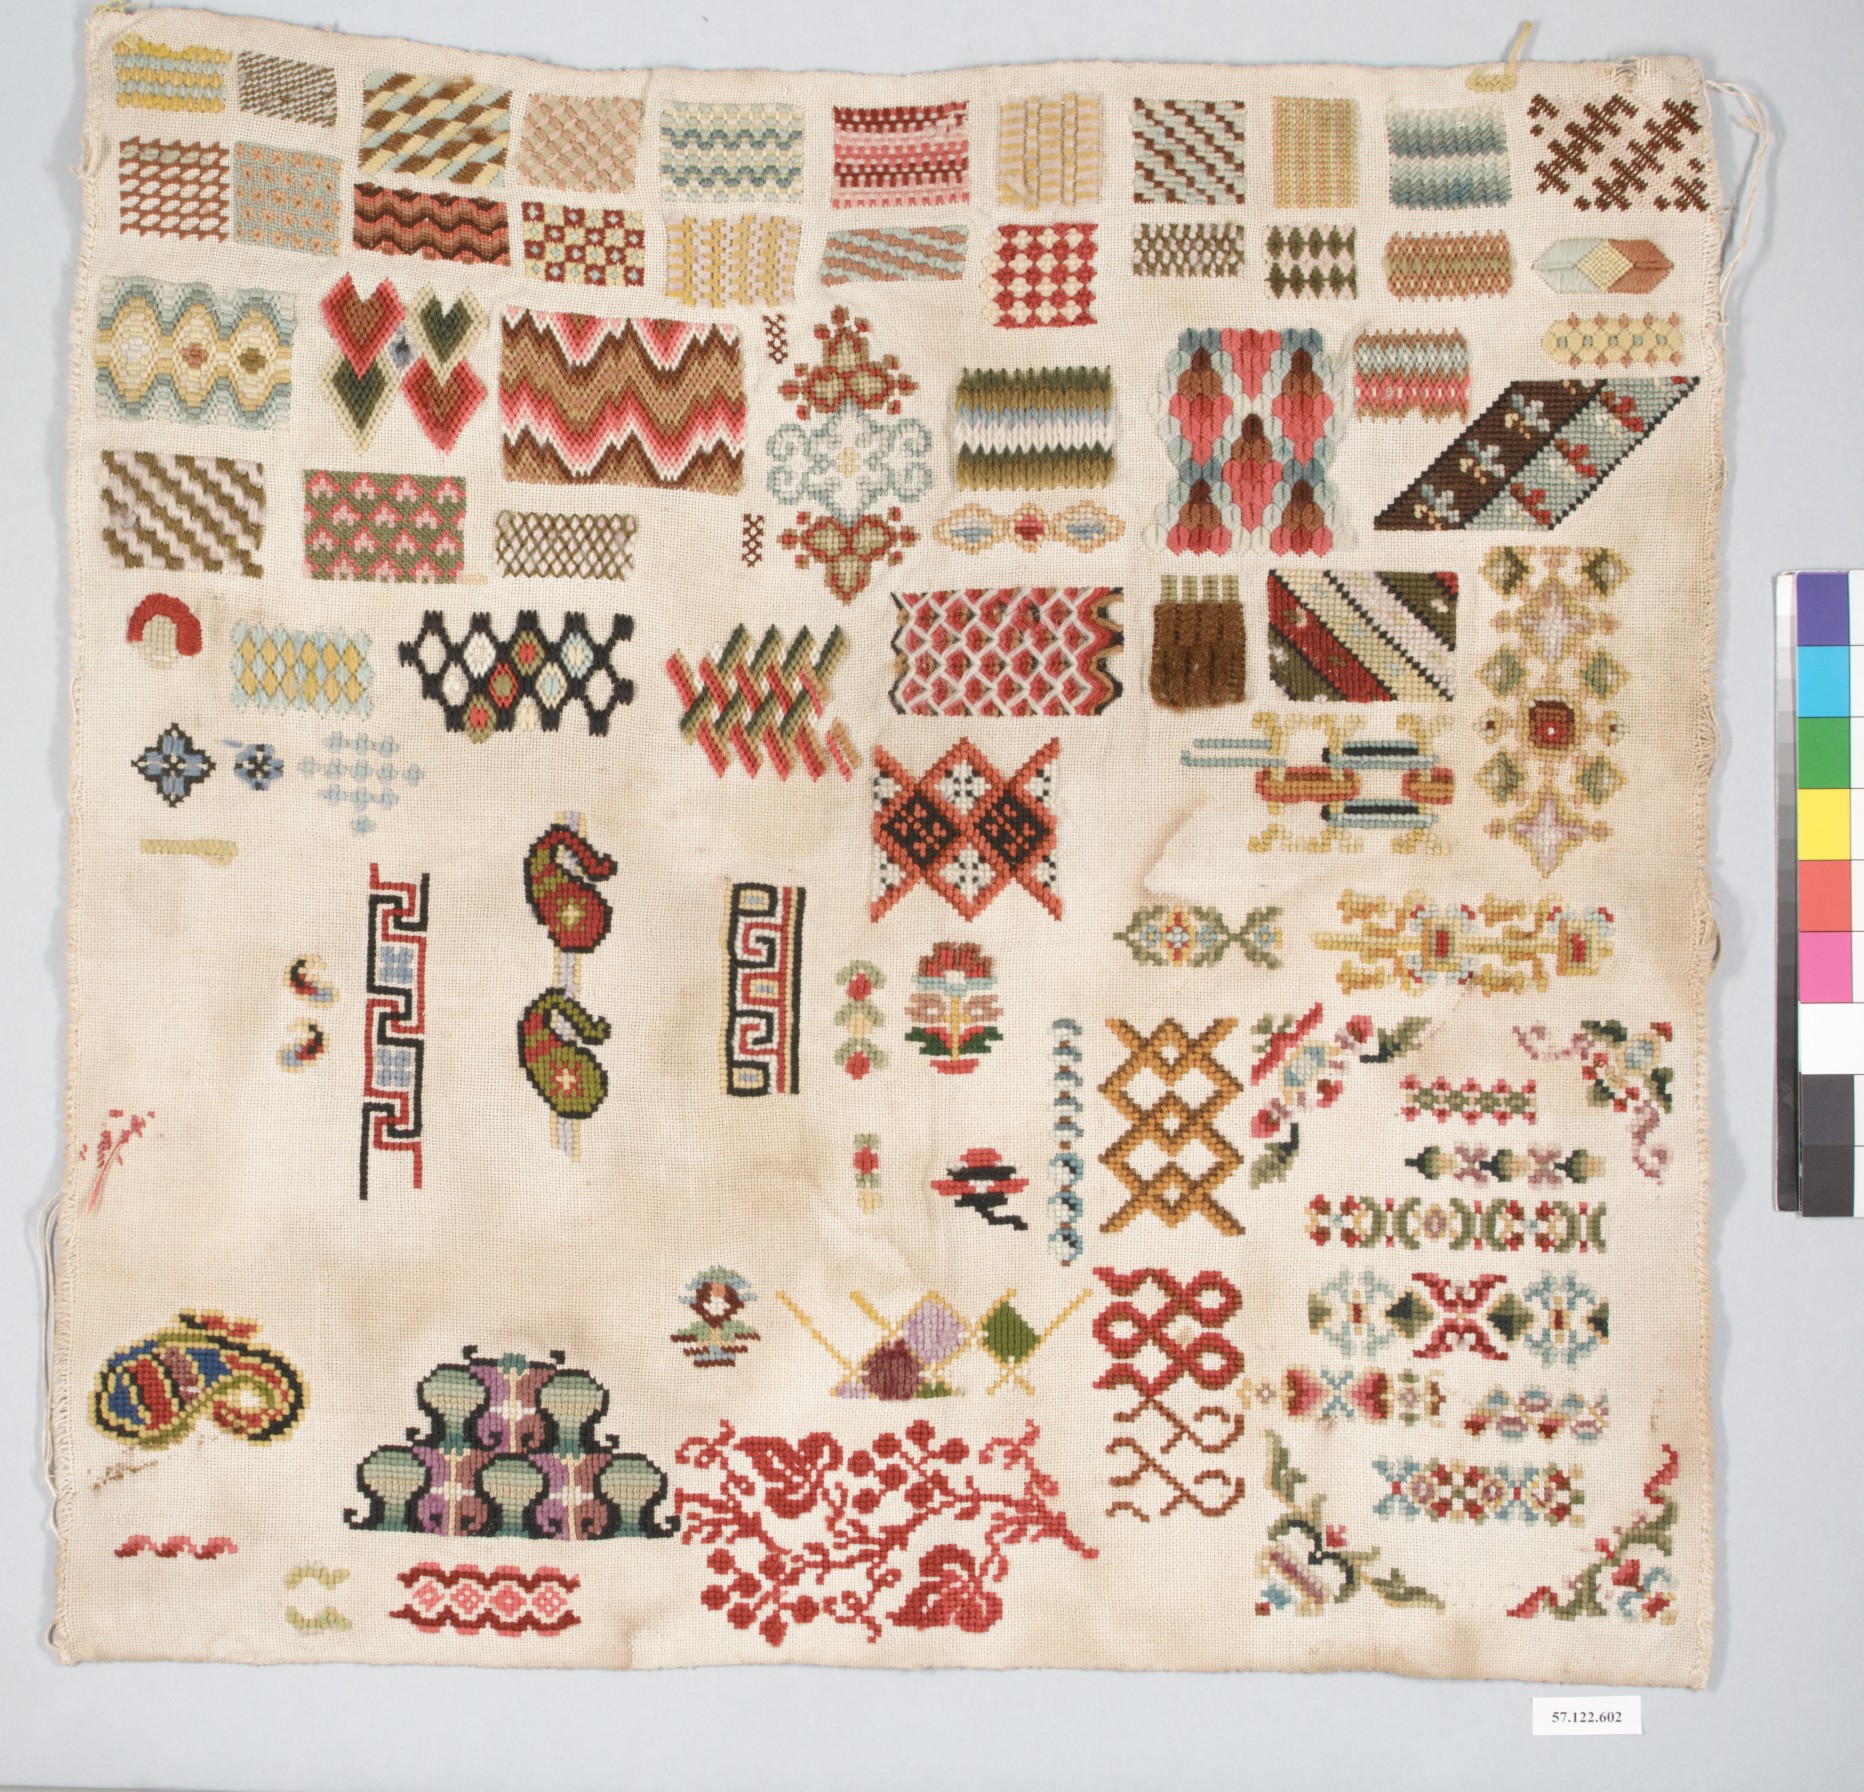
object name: sampler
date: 1801-1900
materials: cotton, wool